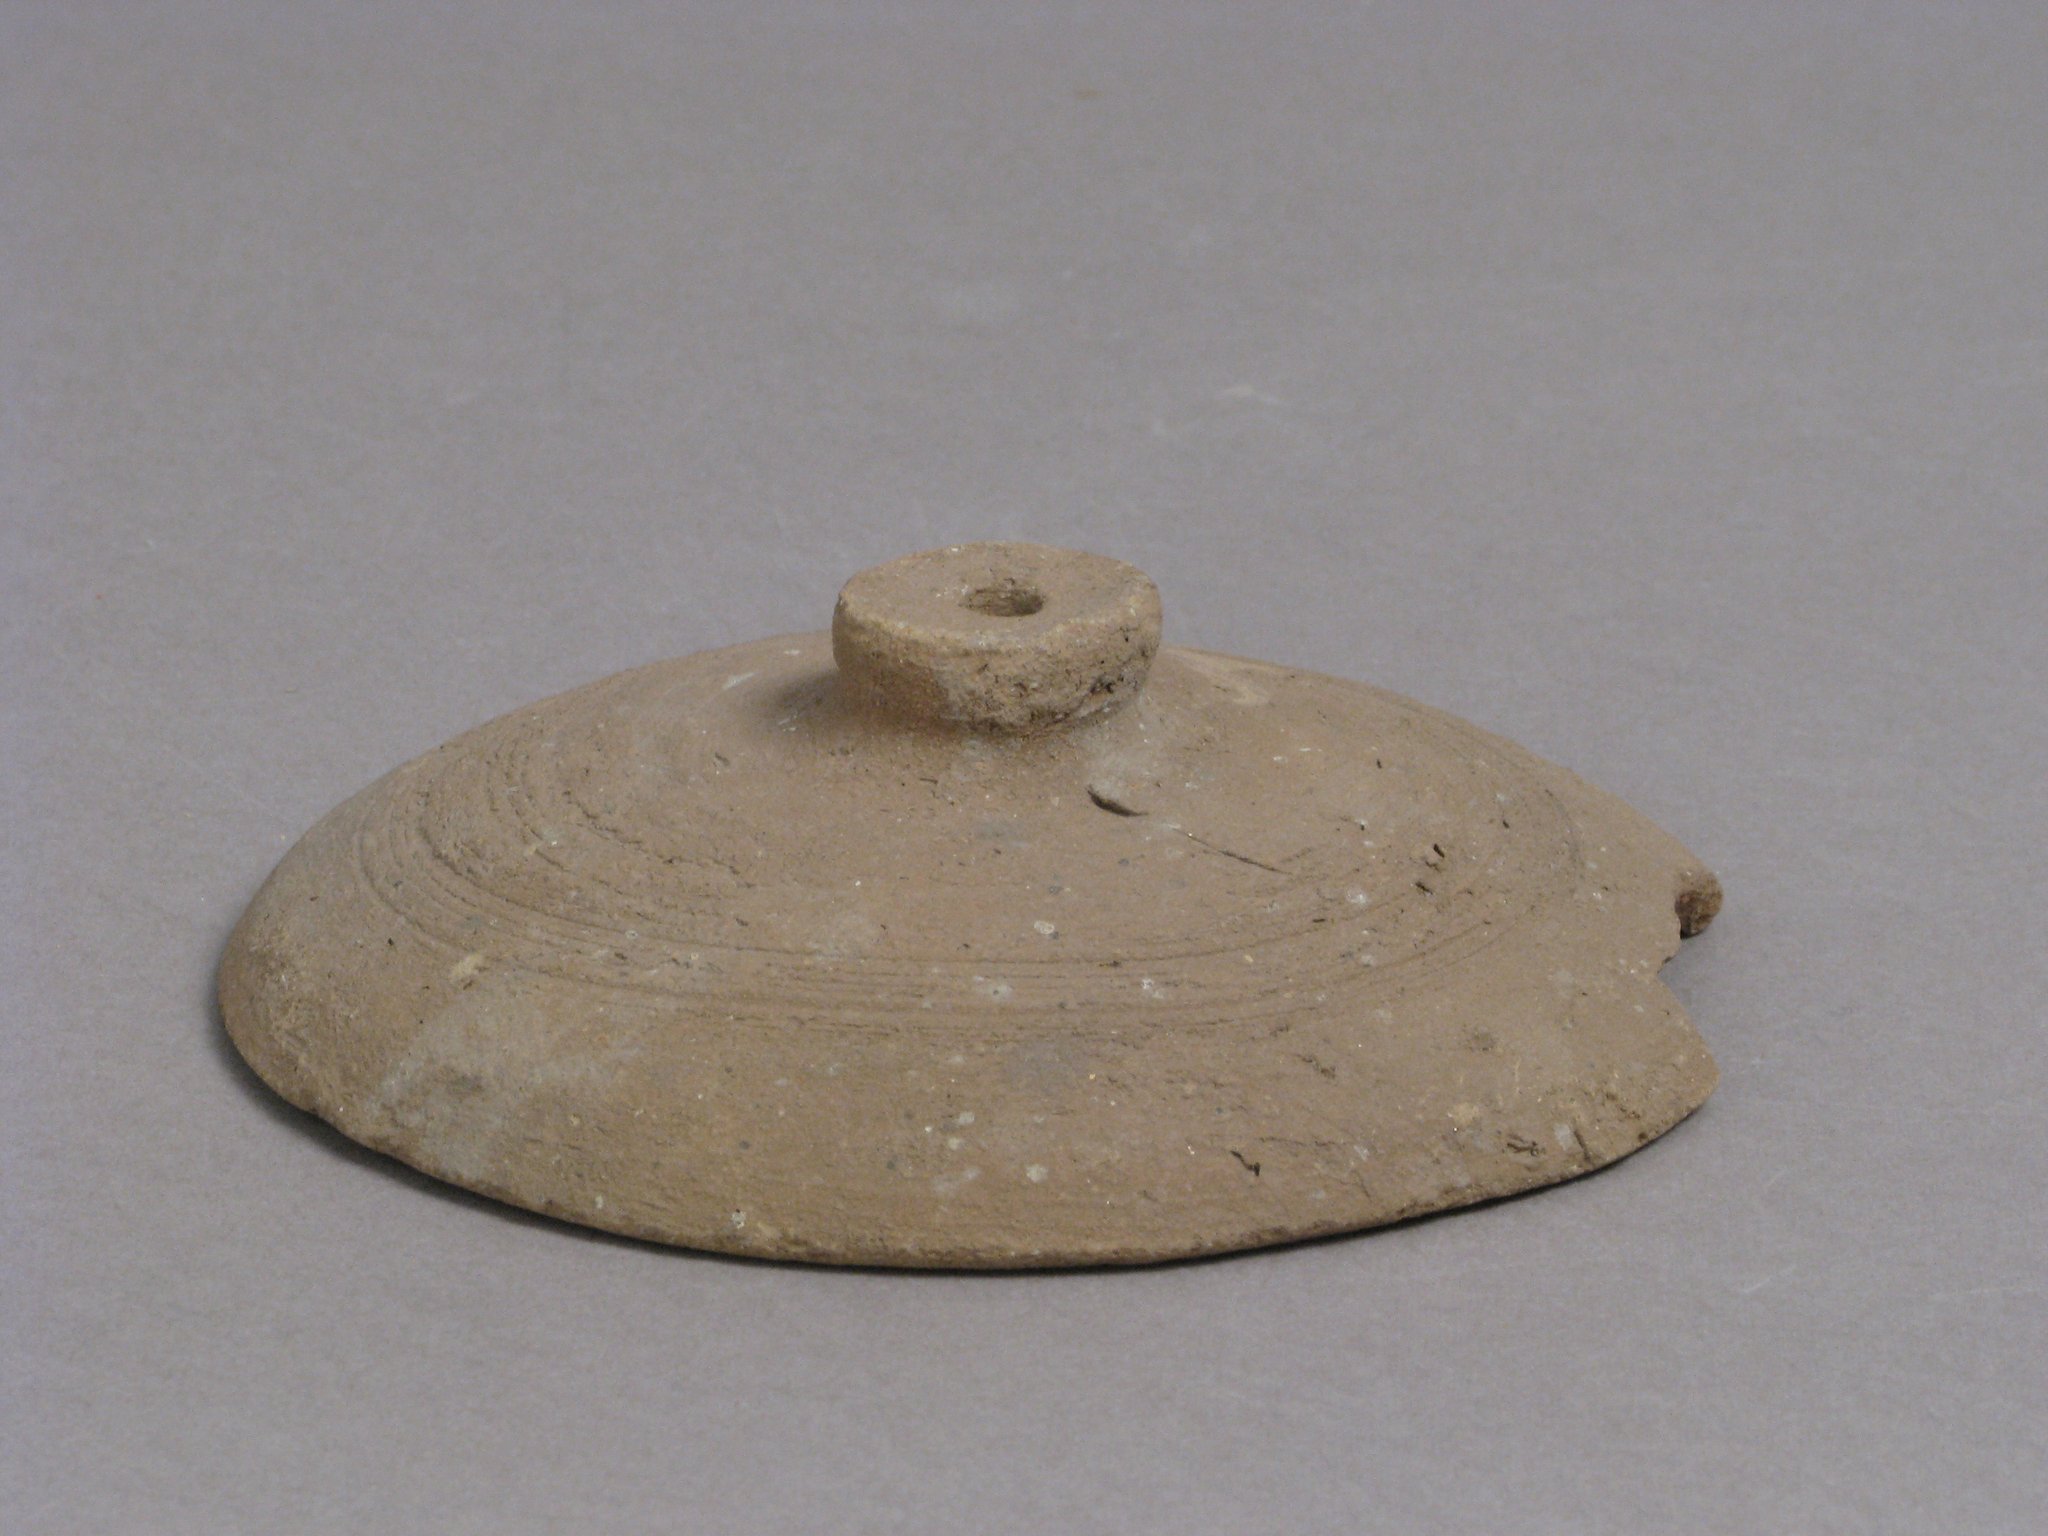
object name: lid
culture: coptic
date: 301-700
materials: earthenware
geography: egypt